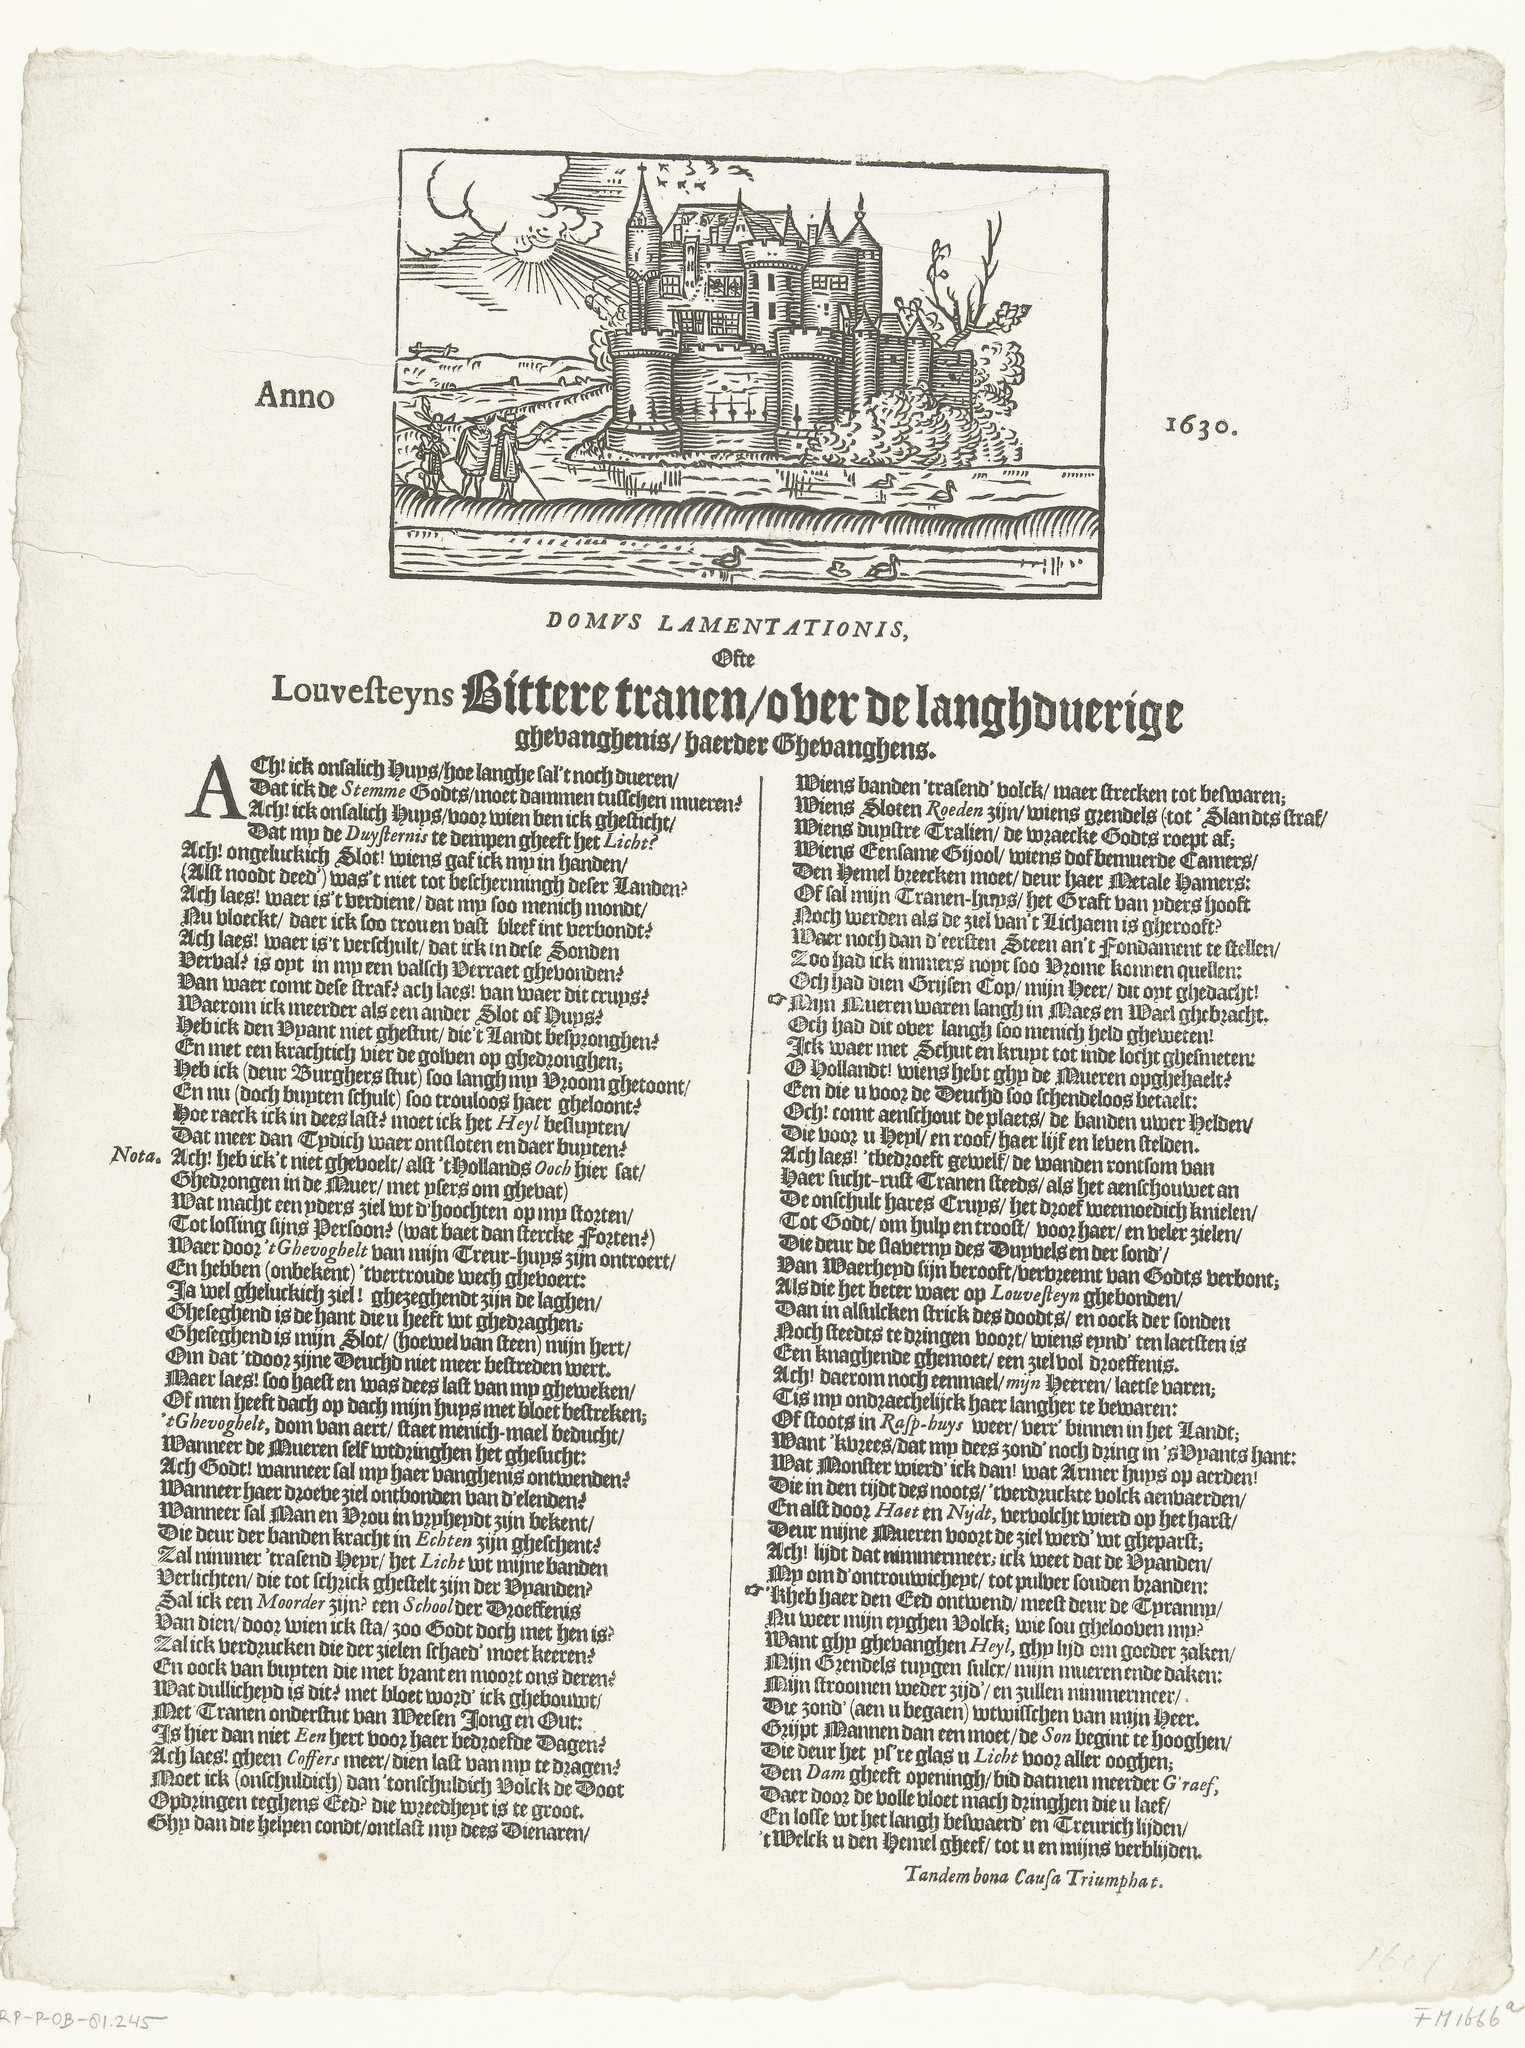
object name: poem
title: Gedicht tegen langdurige opsluiting van de Remonstrantse gevangenen in slot Loevestein, 1630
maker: Anonymous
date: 1630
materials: paper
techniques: letterpress printing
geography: northern netherlands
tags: castle, loevestein castle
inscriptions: date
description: Gedicht tegen langdurige opsluiting van de Remonstrantse gevangenen in slot Loevestein, 1630. Gedicht in 2 kolommen. Bovenaan een gezicht op slot Loevestein.